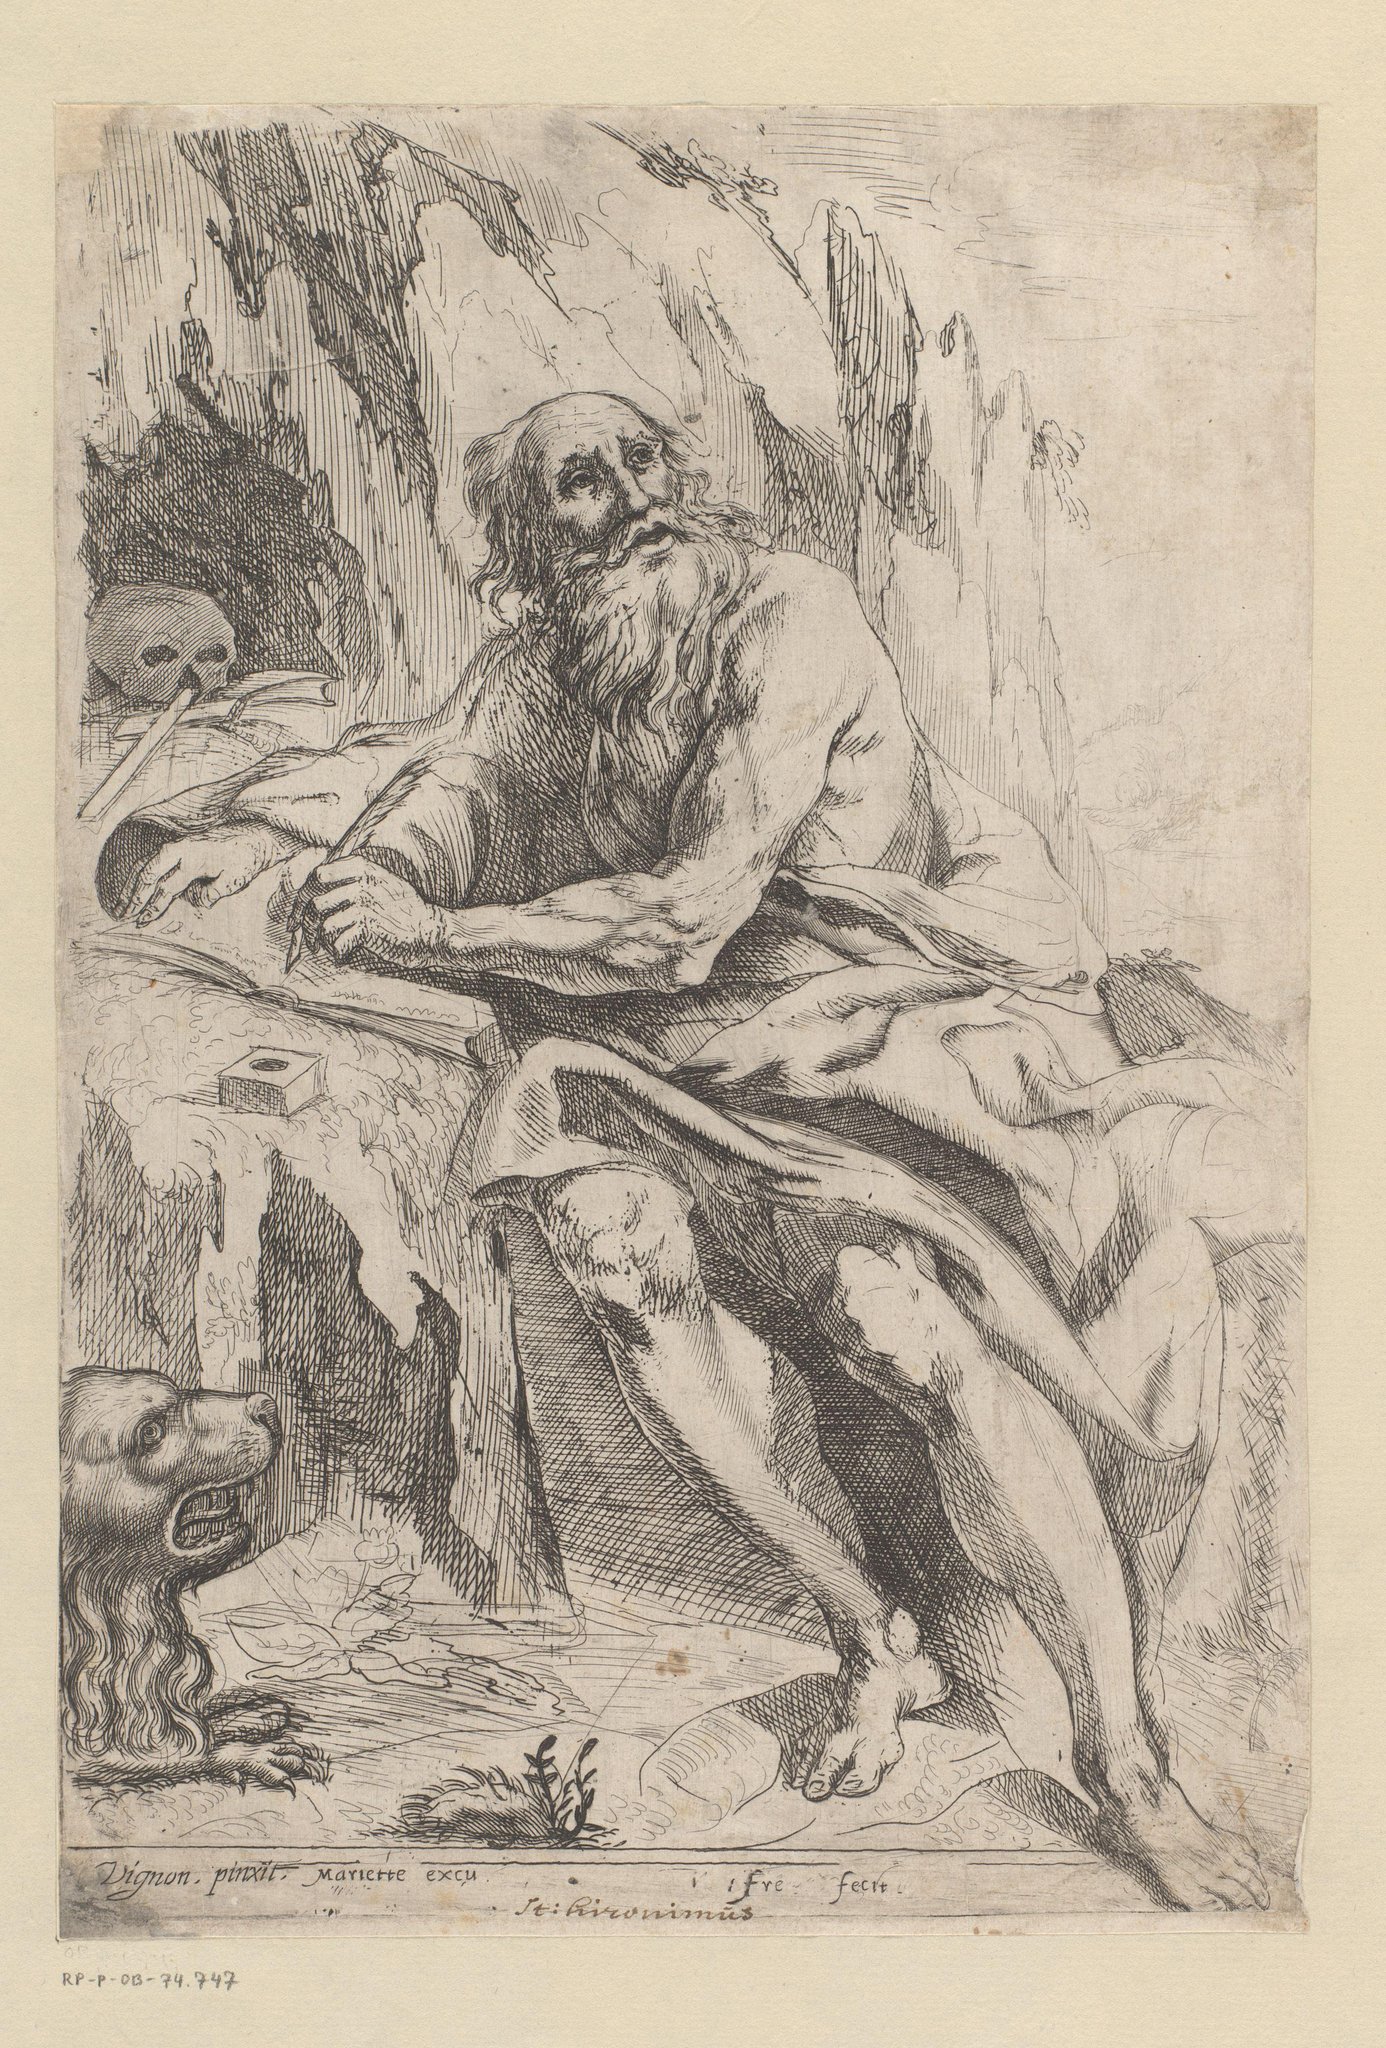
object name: print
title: H. Hieronymus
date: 1603-1630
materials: paper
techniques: etching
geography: france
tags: the monk and hermit jerome (hieronymus); possible attributes: book, cardinal's hat, crucifix, hour-glass, lion, skull, stone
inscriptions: inscription: ‘St: hironimus’, collector's mark: Lugt 240